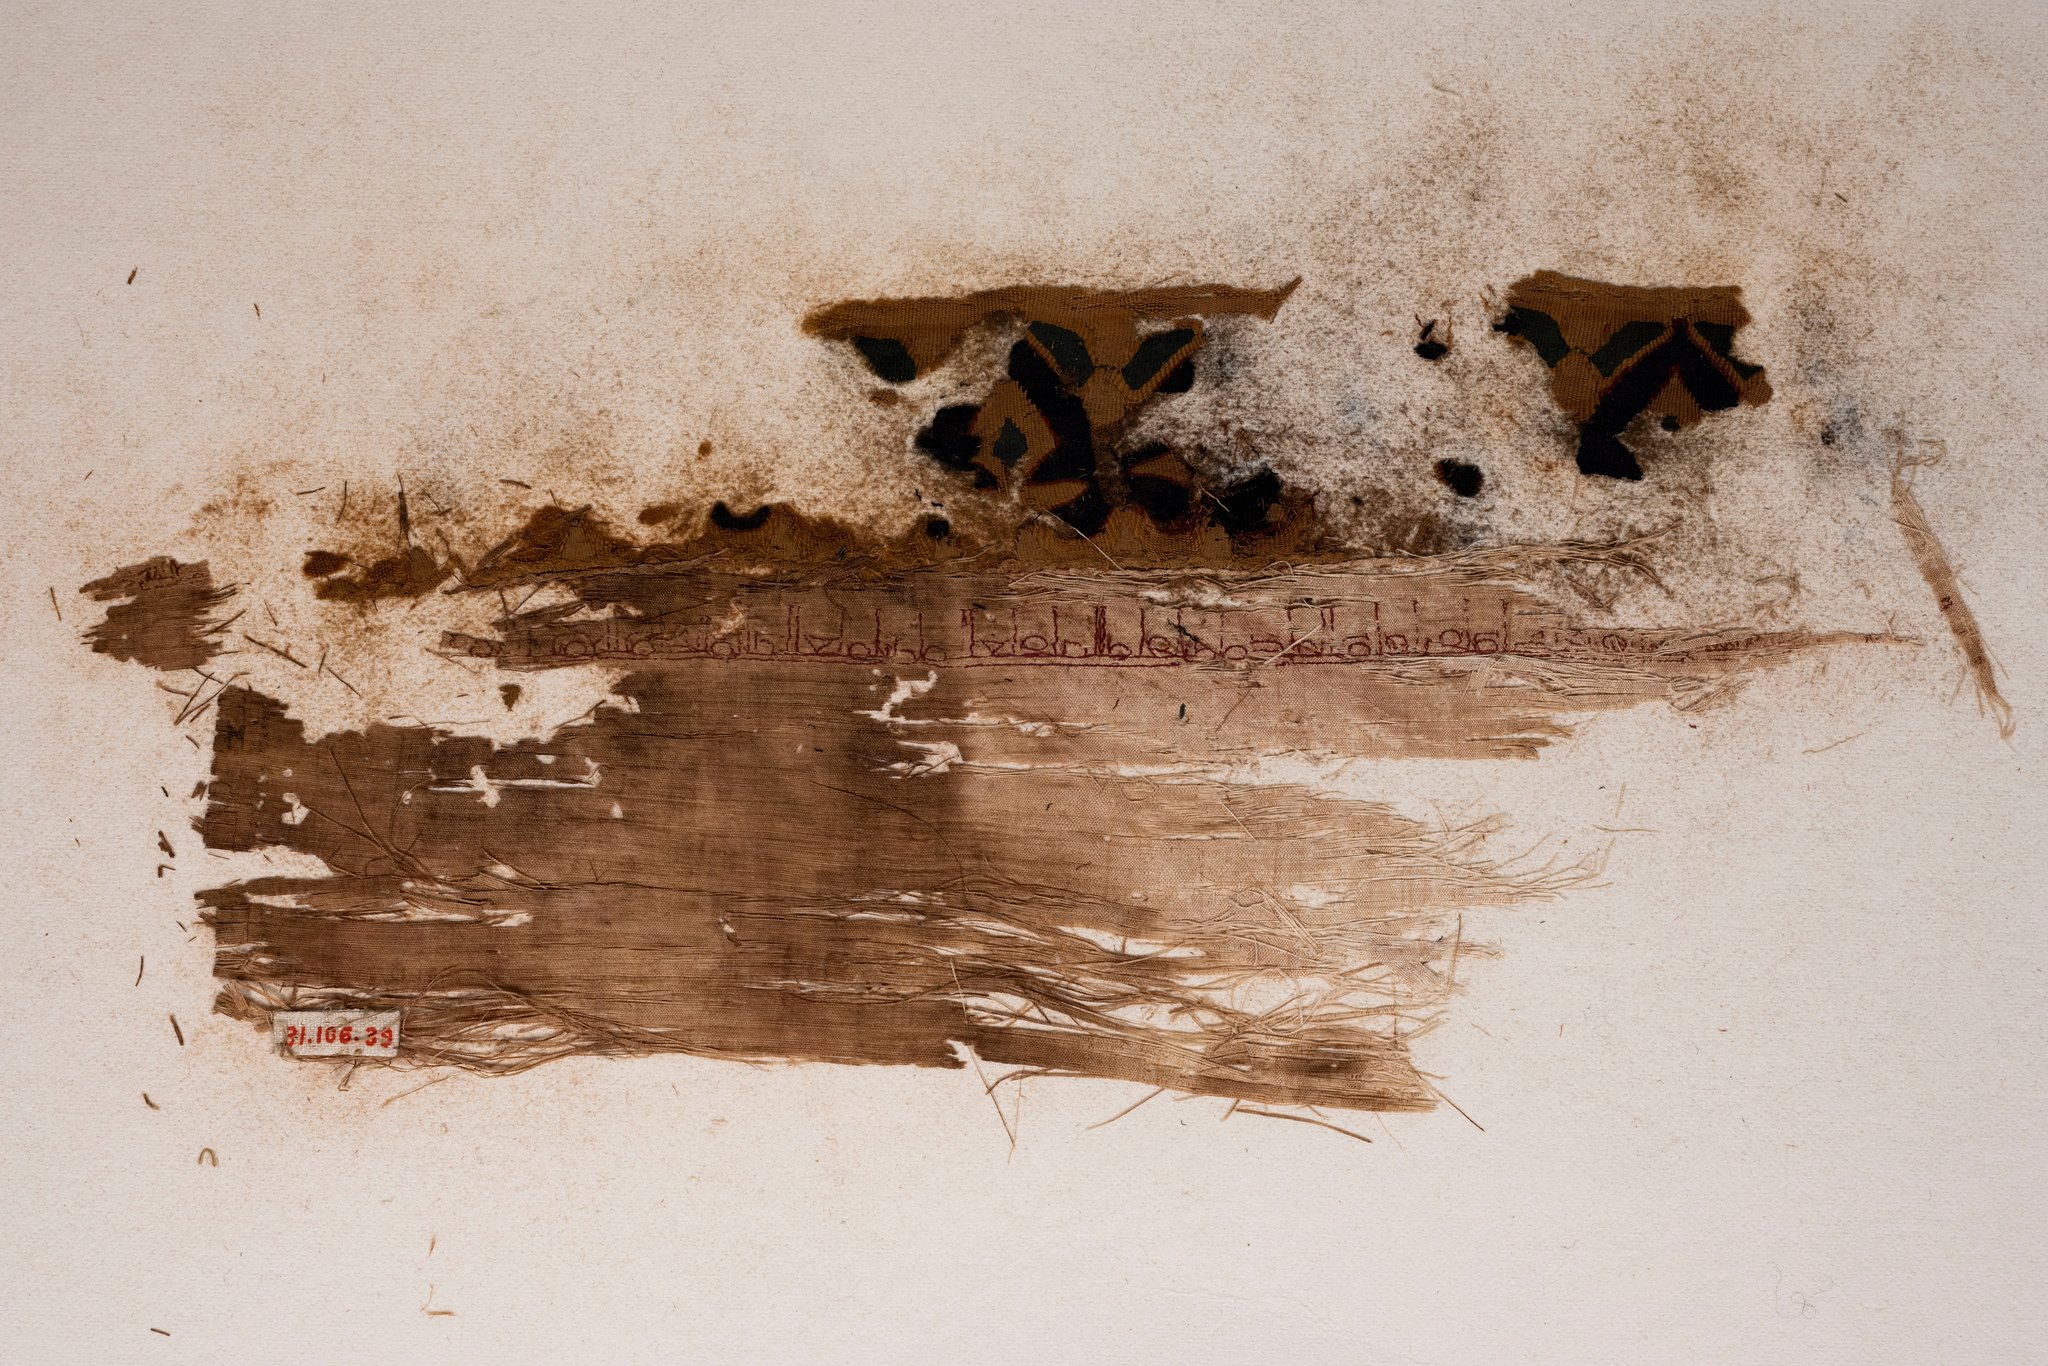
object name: textile fragment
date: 901-1000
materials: linen, silk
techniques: embroidery, weave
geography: egypt